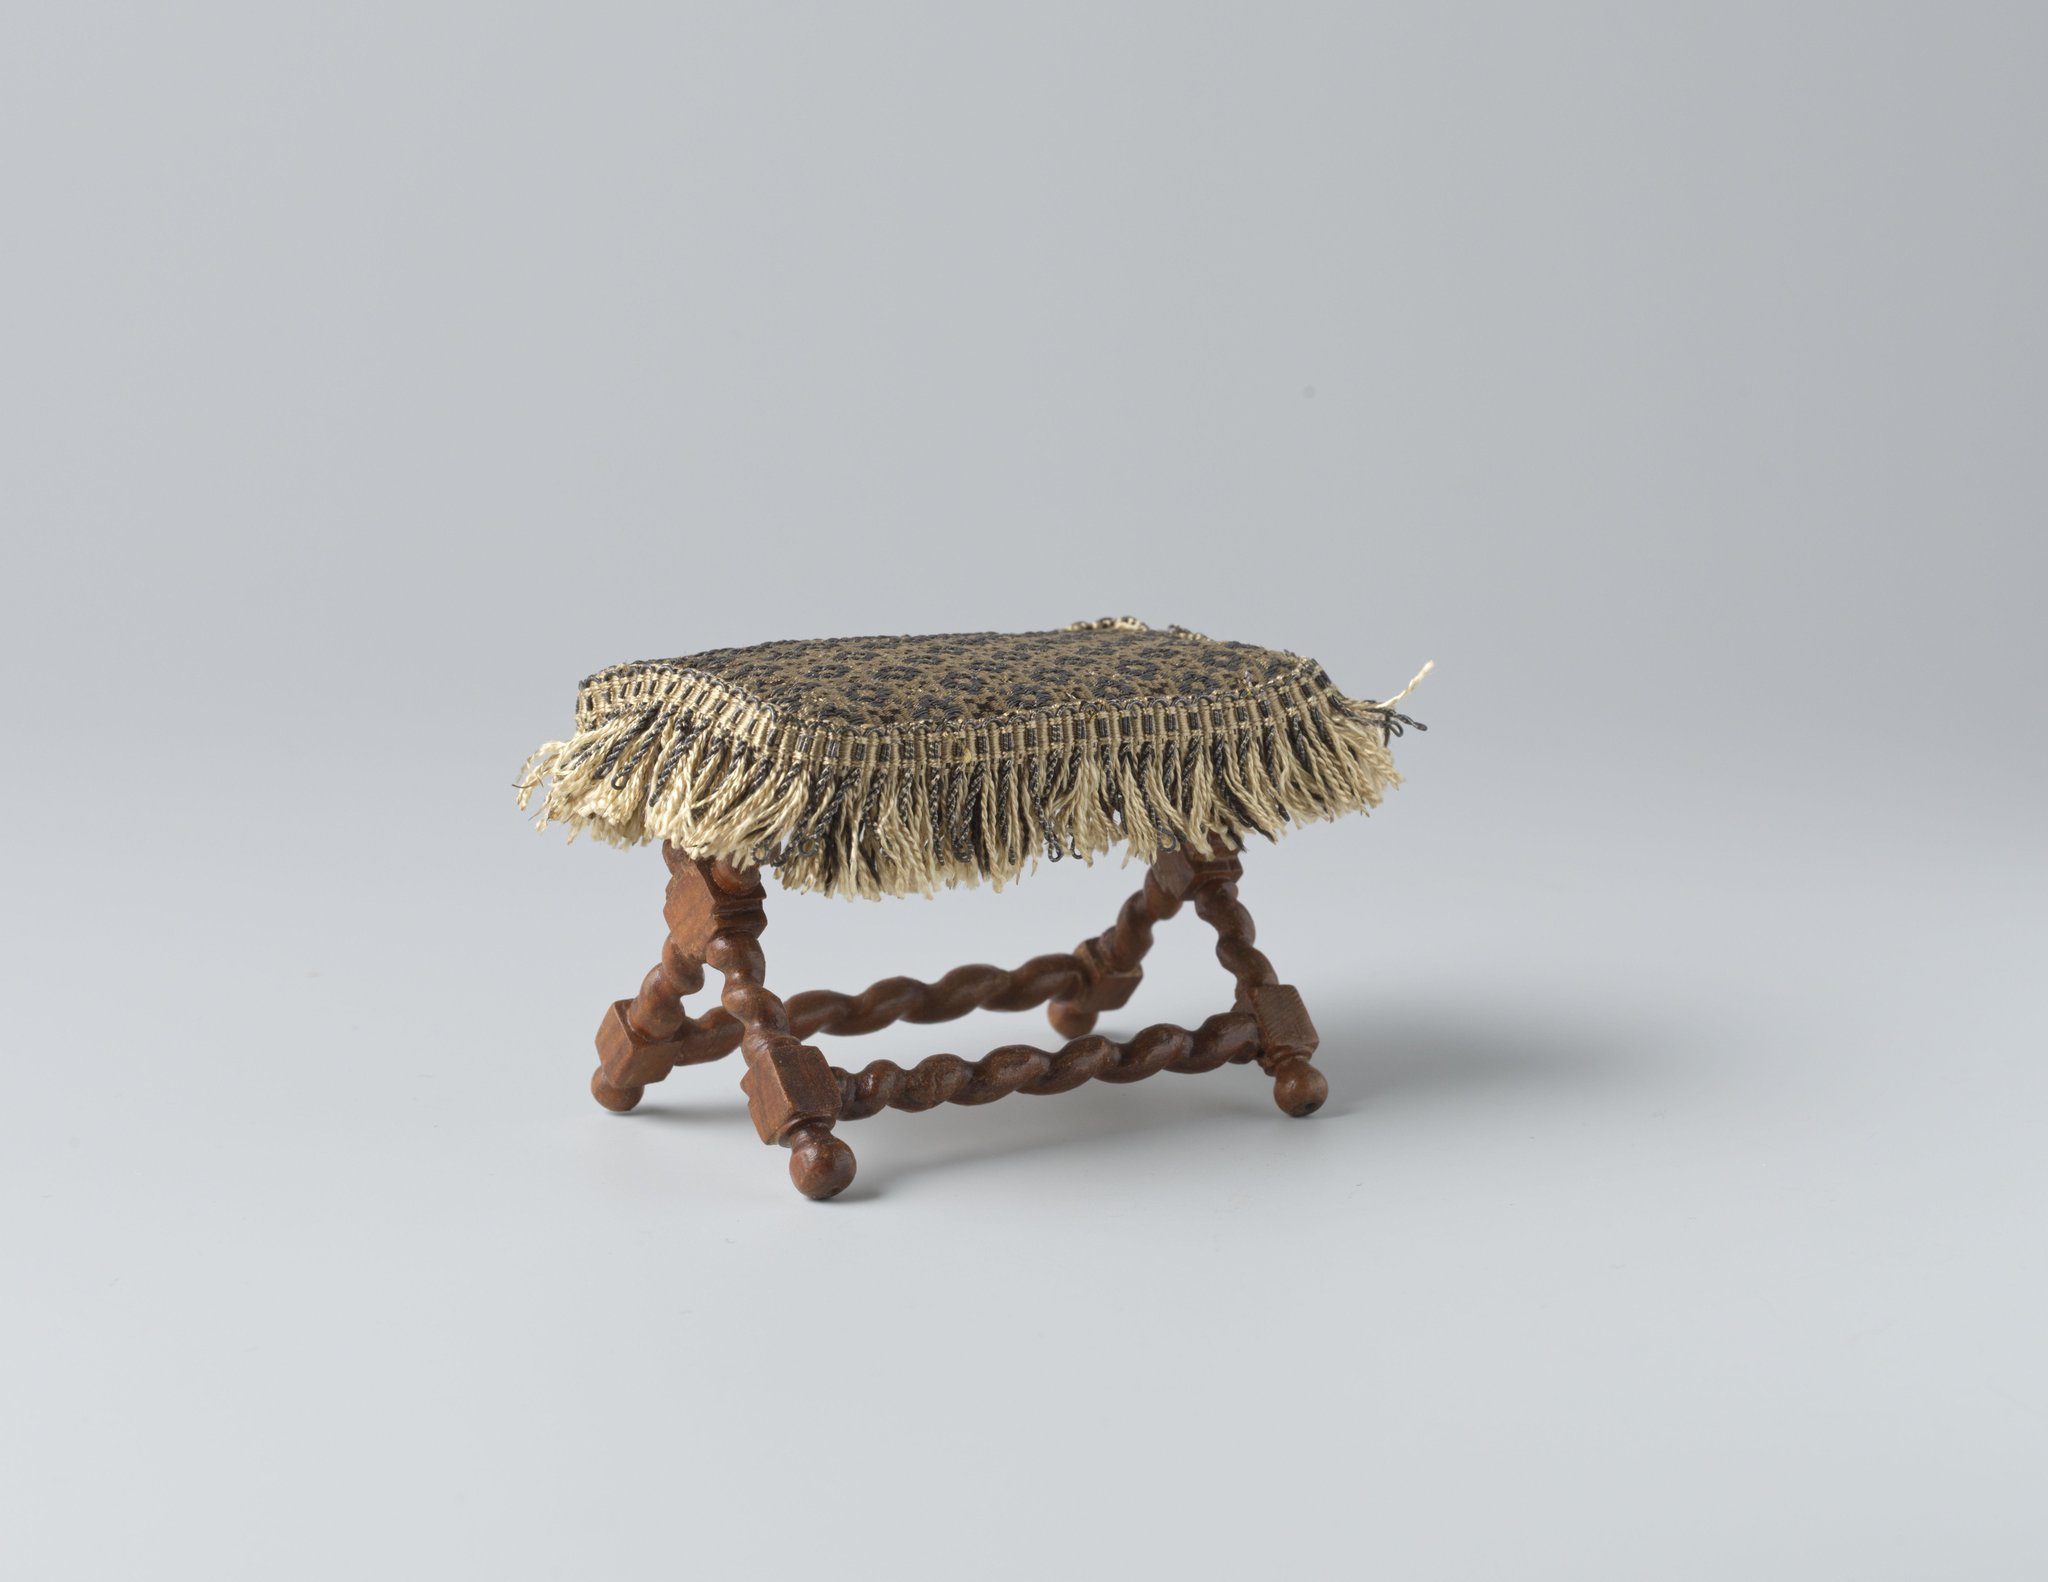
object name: miniature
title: Taboeret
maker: Anonymous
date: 1676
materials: linen, wood, silk, thread, wool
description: Taboeret met rechthoekige zitting, op getorste poten van olijfhout, de poten zijn twee aan twee gekruist en worden verbonden aan de onderzijde door twee getorste dwarspoten, en boven door twee gladde dwarsregels. Tussen de bovenregels is de zitting gespannen, bestaande uit een linnen onderlaag, waarop wolpluis, afgedekt door een complex weefsel van zijde en metaaldraad met geometrisch patroon in de kleuren geel en zwart. De stof is rondom afgezet met passement met franje van dezelfde gele en zwarte zijde en verguld zilverdraad.